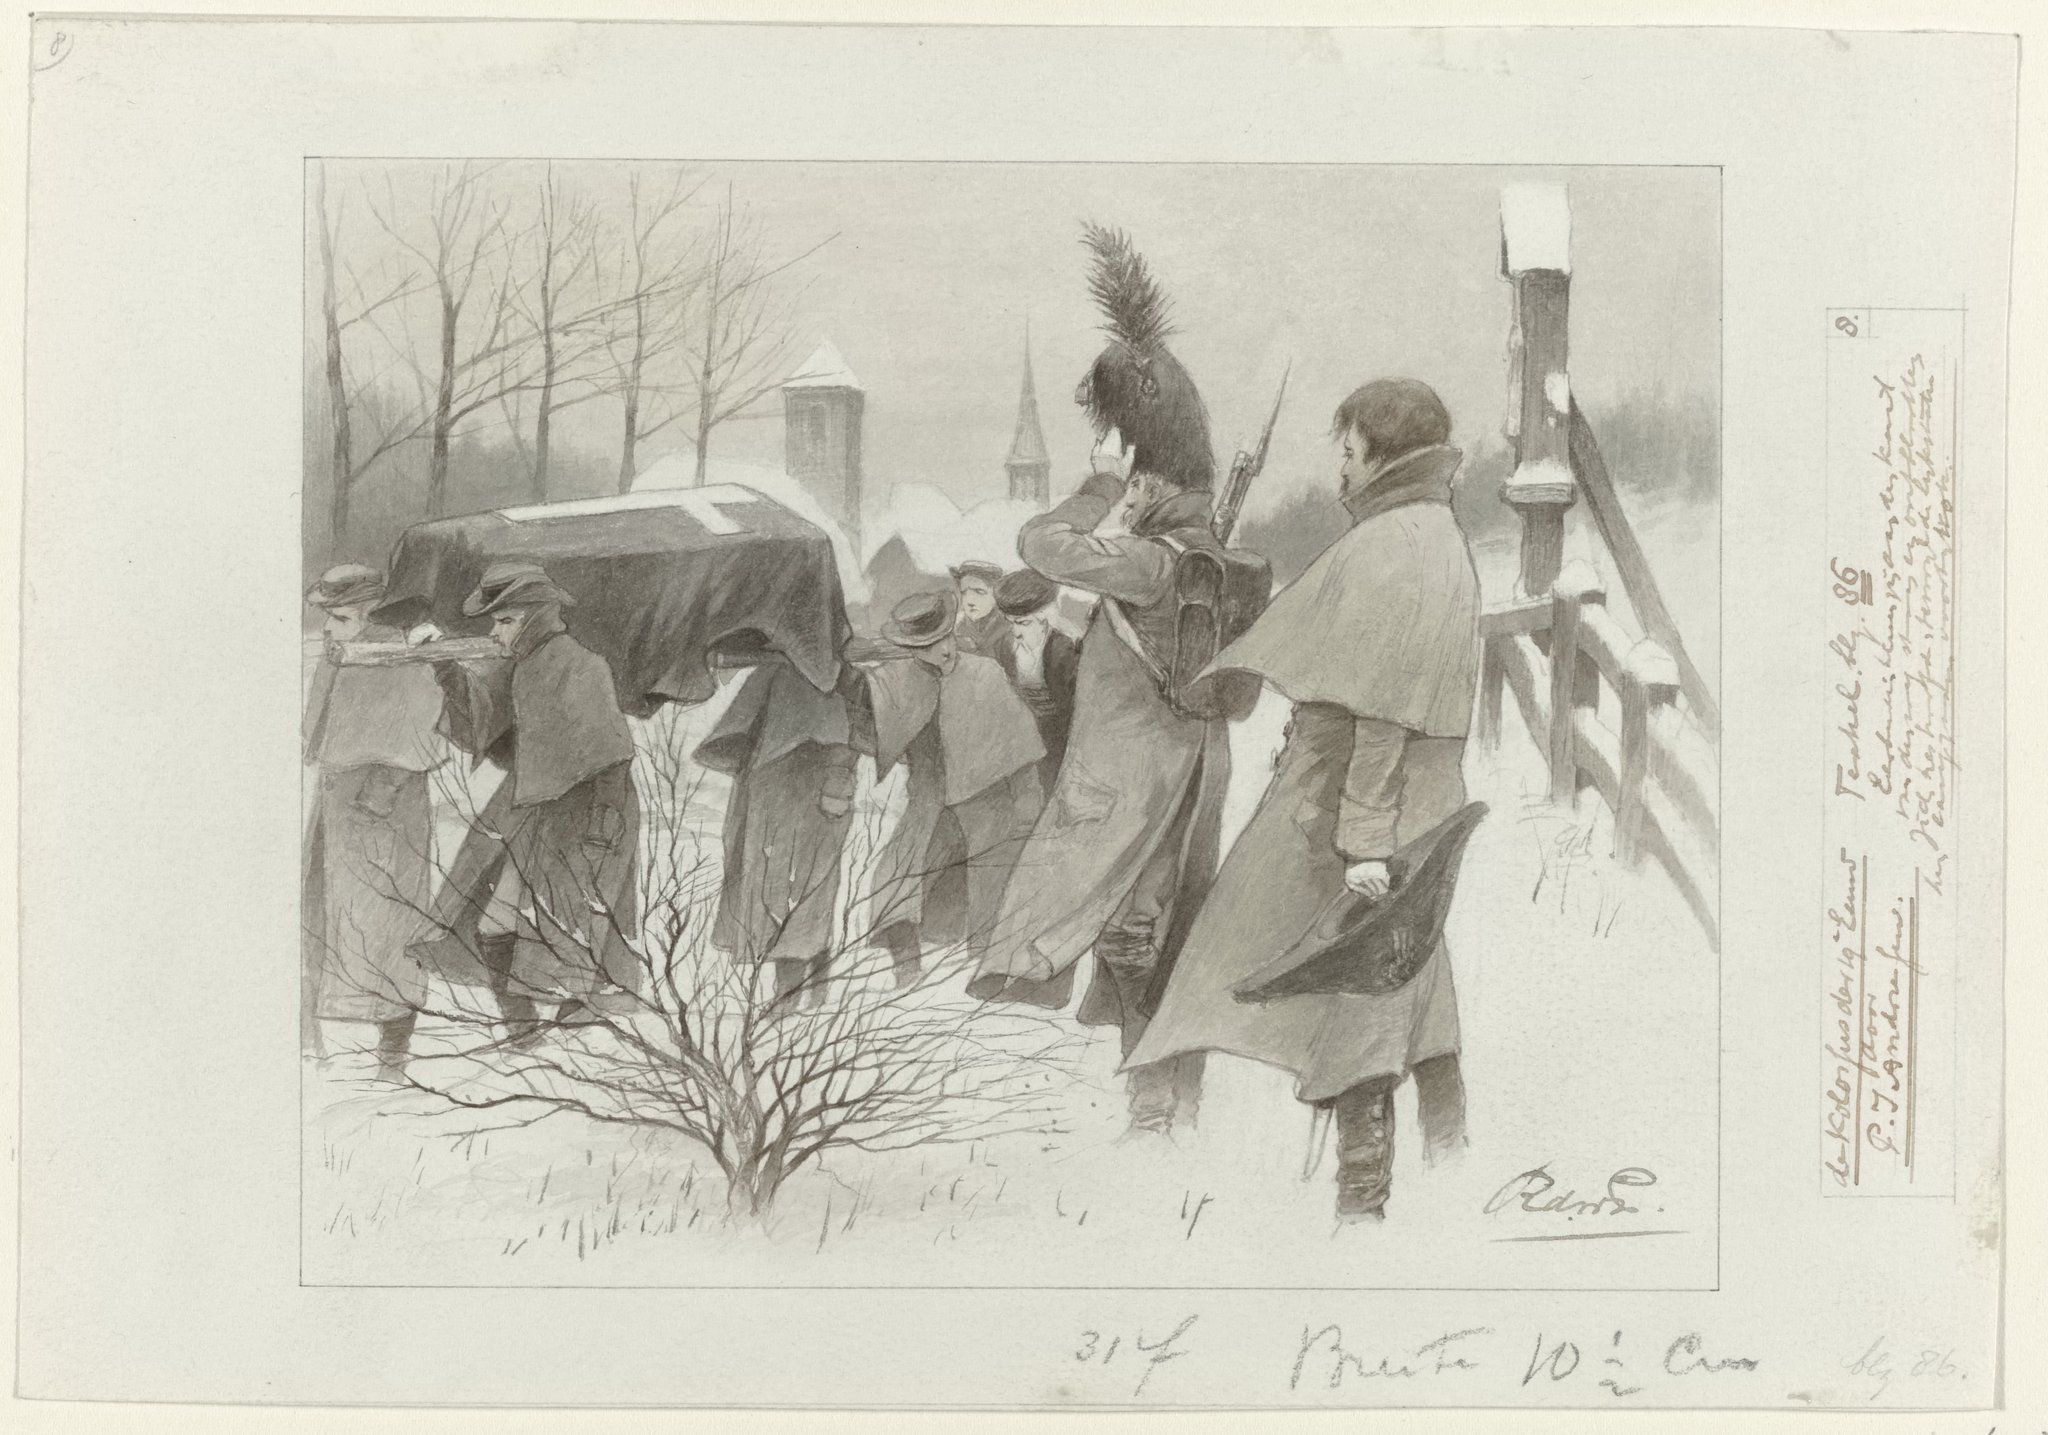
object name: drawing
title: Ontwerp voor illustratie voor De Kolossus der Negentiende Eeuw door P.J. Andriessen (Textill., blz. 86); scène uit het leven van Napoleon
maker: george lodewijk de wetstein pfister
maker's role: draughtsman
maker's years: 1867-1942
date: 1877-1942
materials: ink, paper, pencil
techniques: brush, pen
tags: napoleon i (emperor of the french), (andriessen, de kolossus der negentiende eeuw) specific works of literature (with author, title), historical persons, illustration ~ printed matter, book, historical events and situations